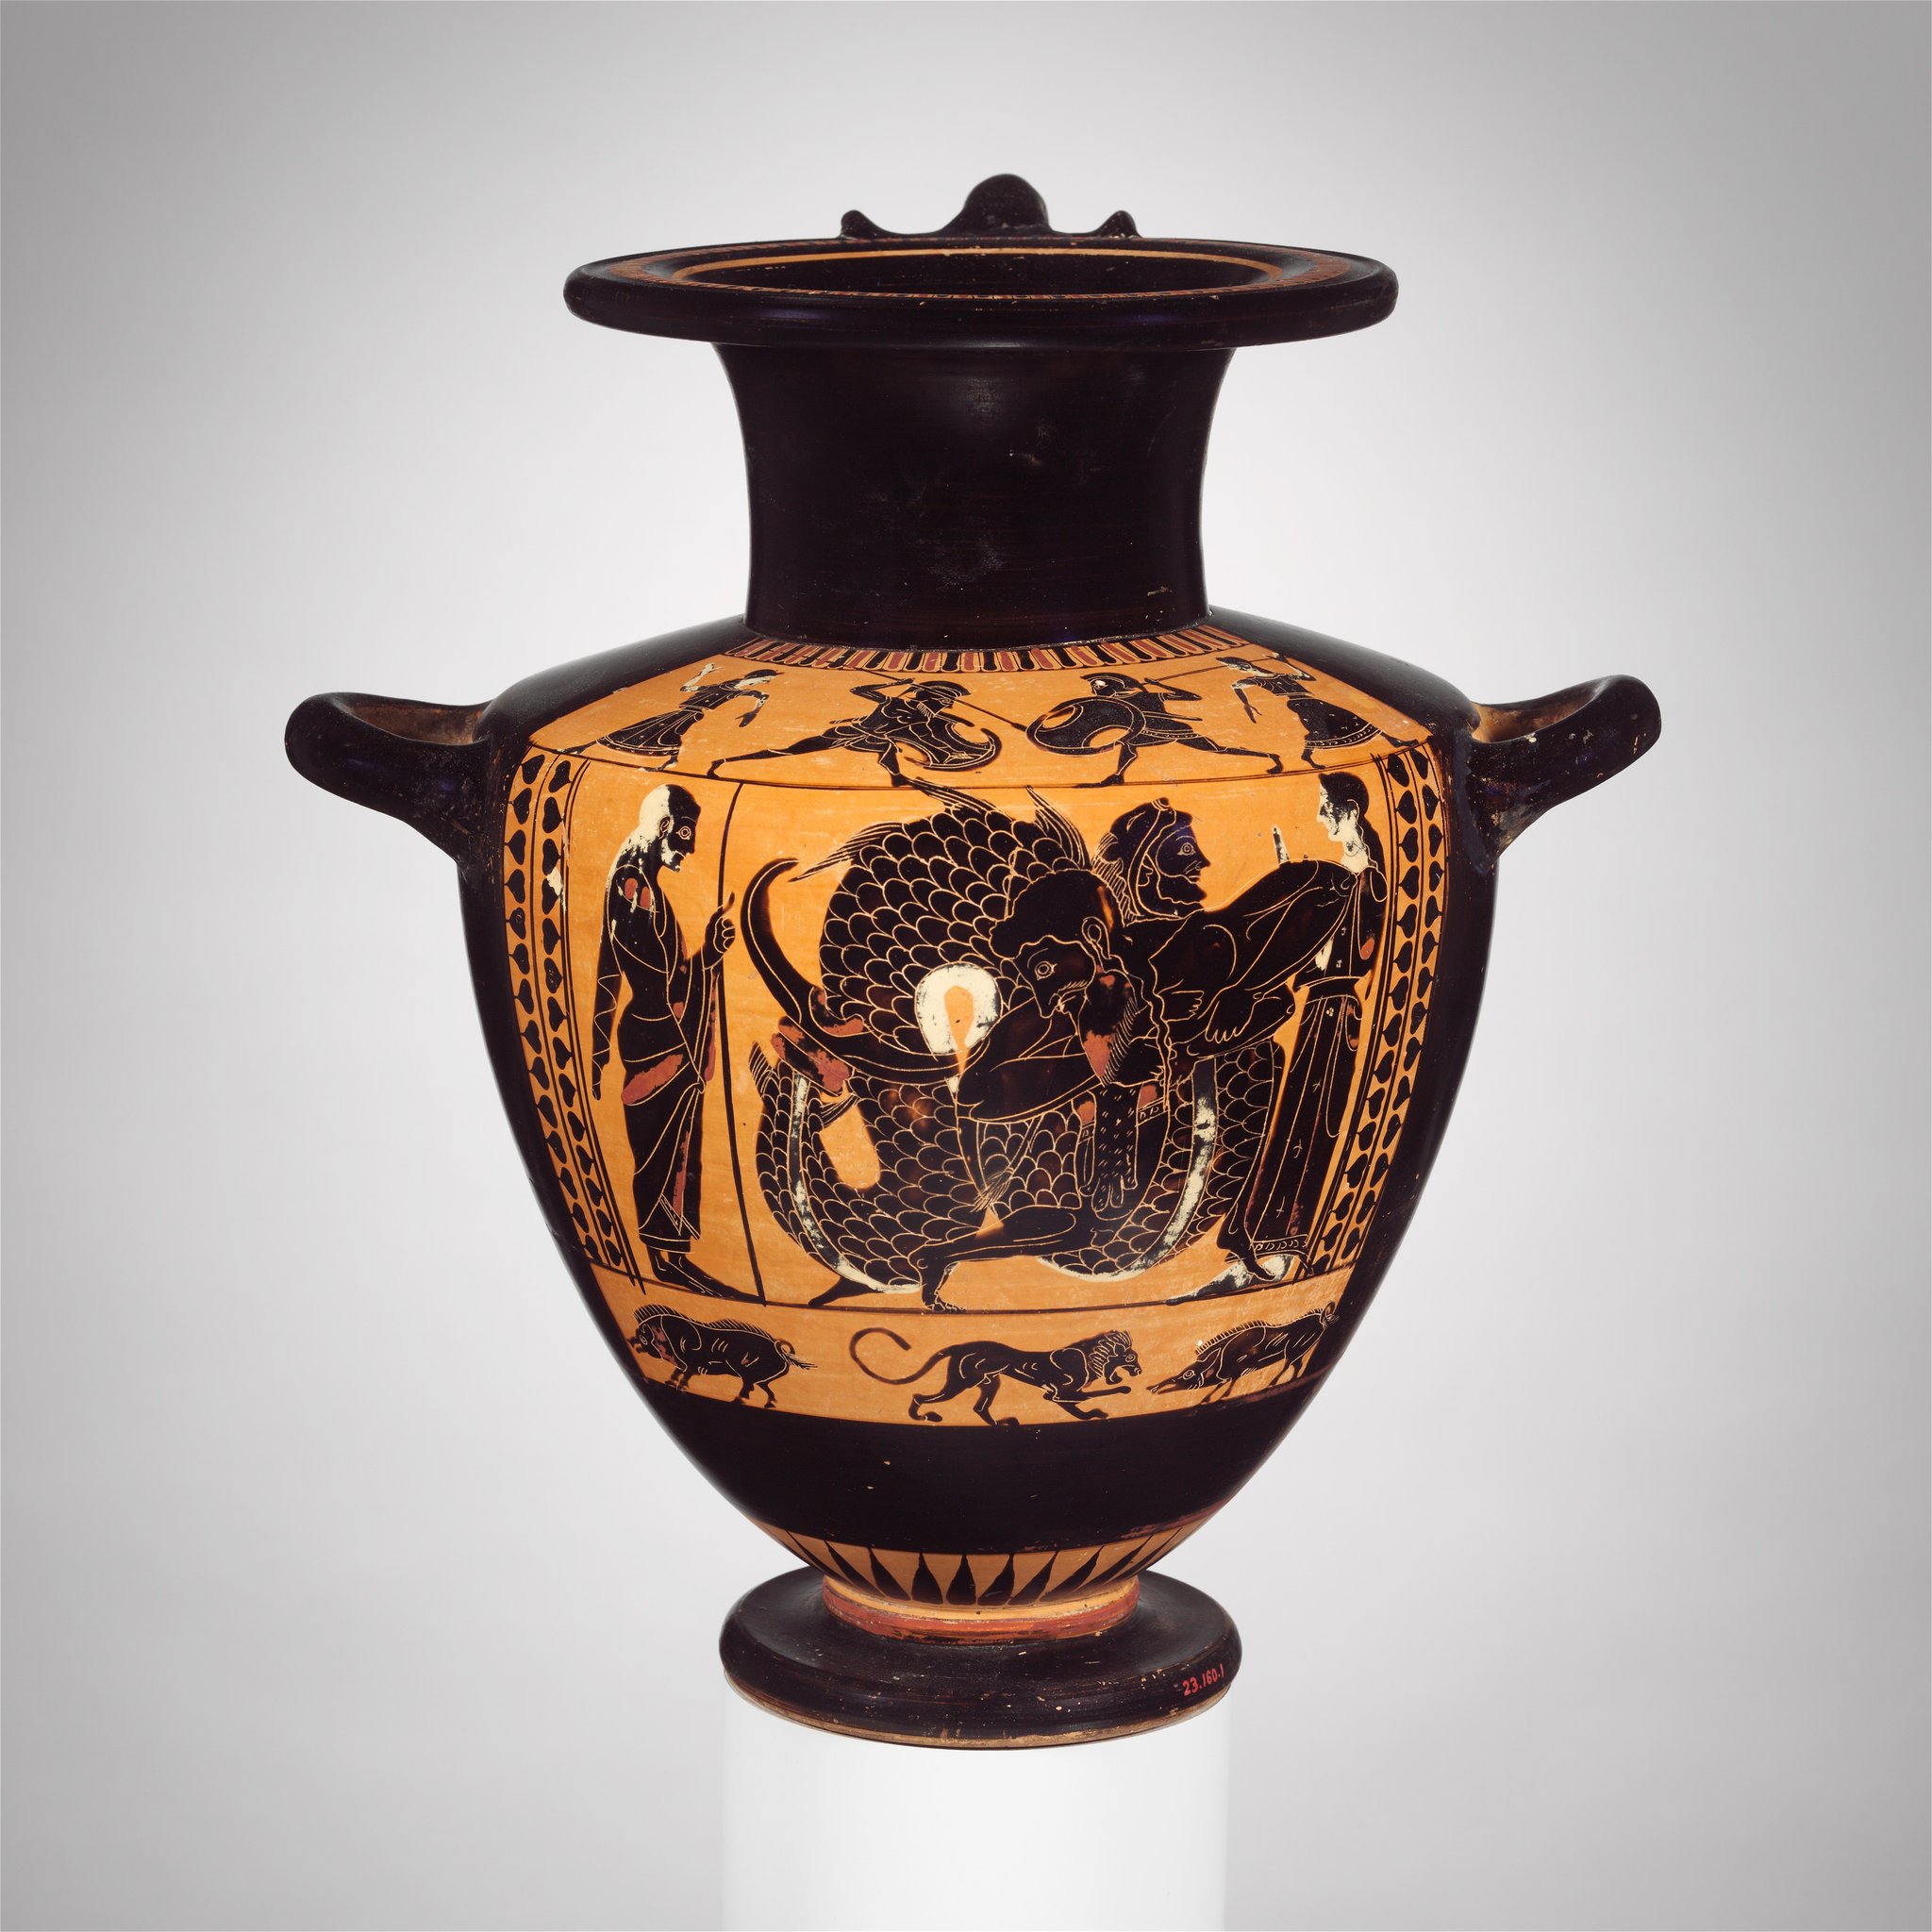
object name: hydria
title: Terracotta hydria (water jar)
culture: greek, attic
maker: antimenes painter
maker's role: artist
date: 530-520 BCE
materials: terracotta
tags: animals,men,women,triton